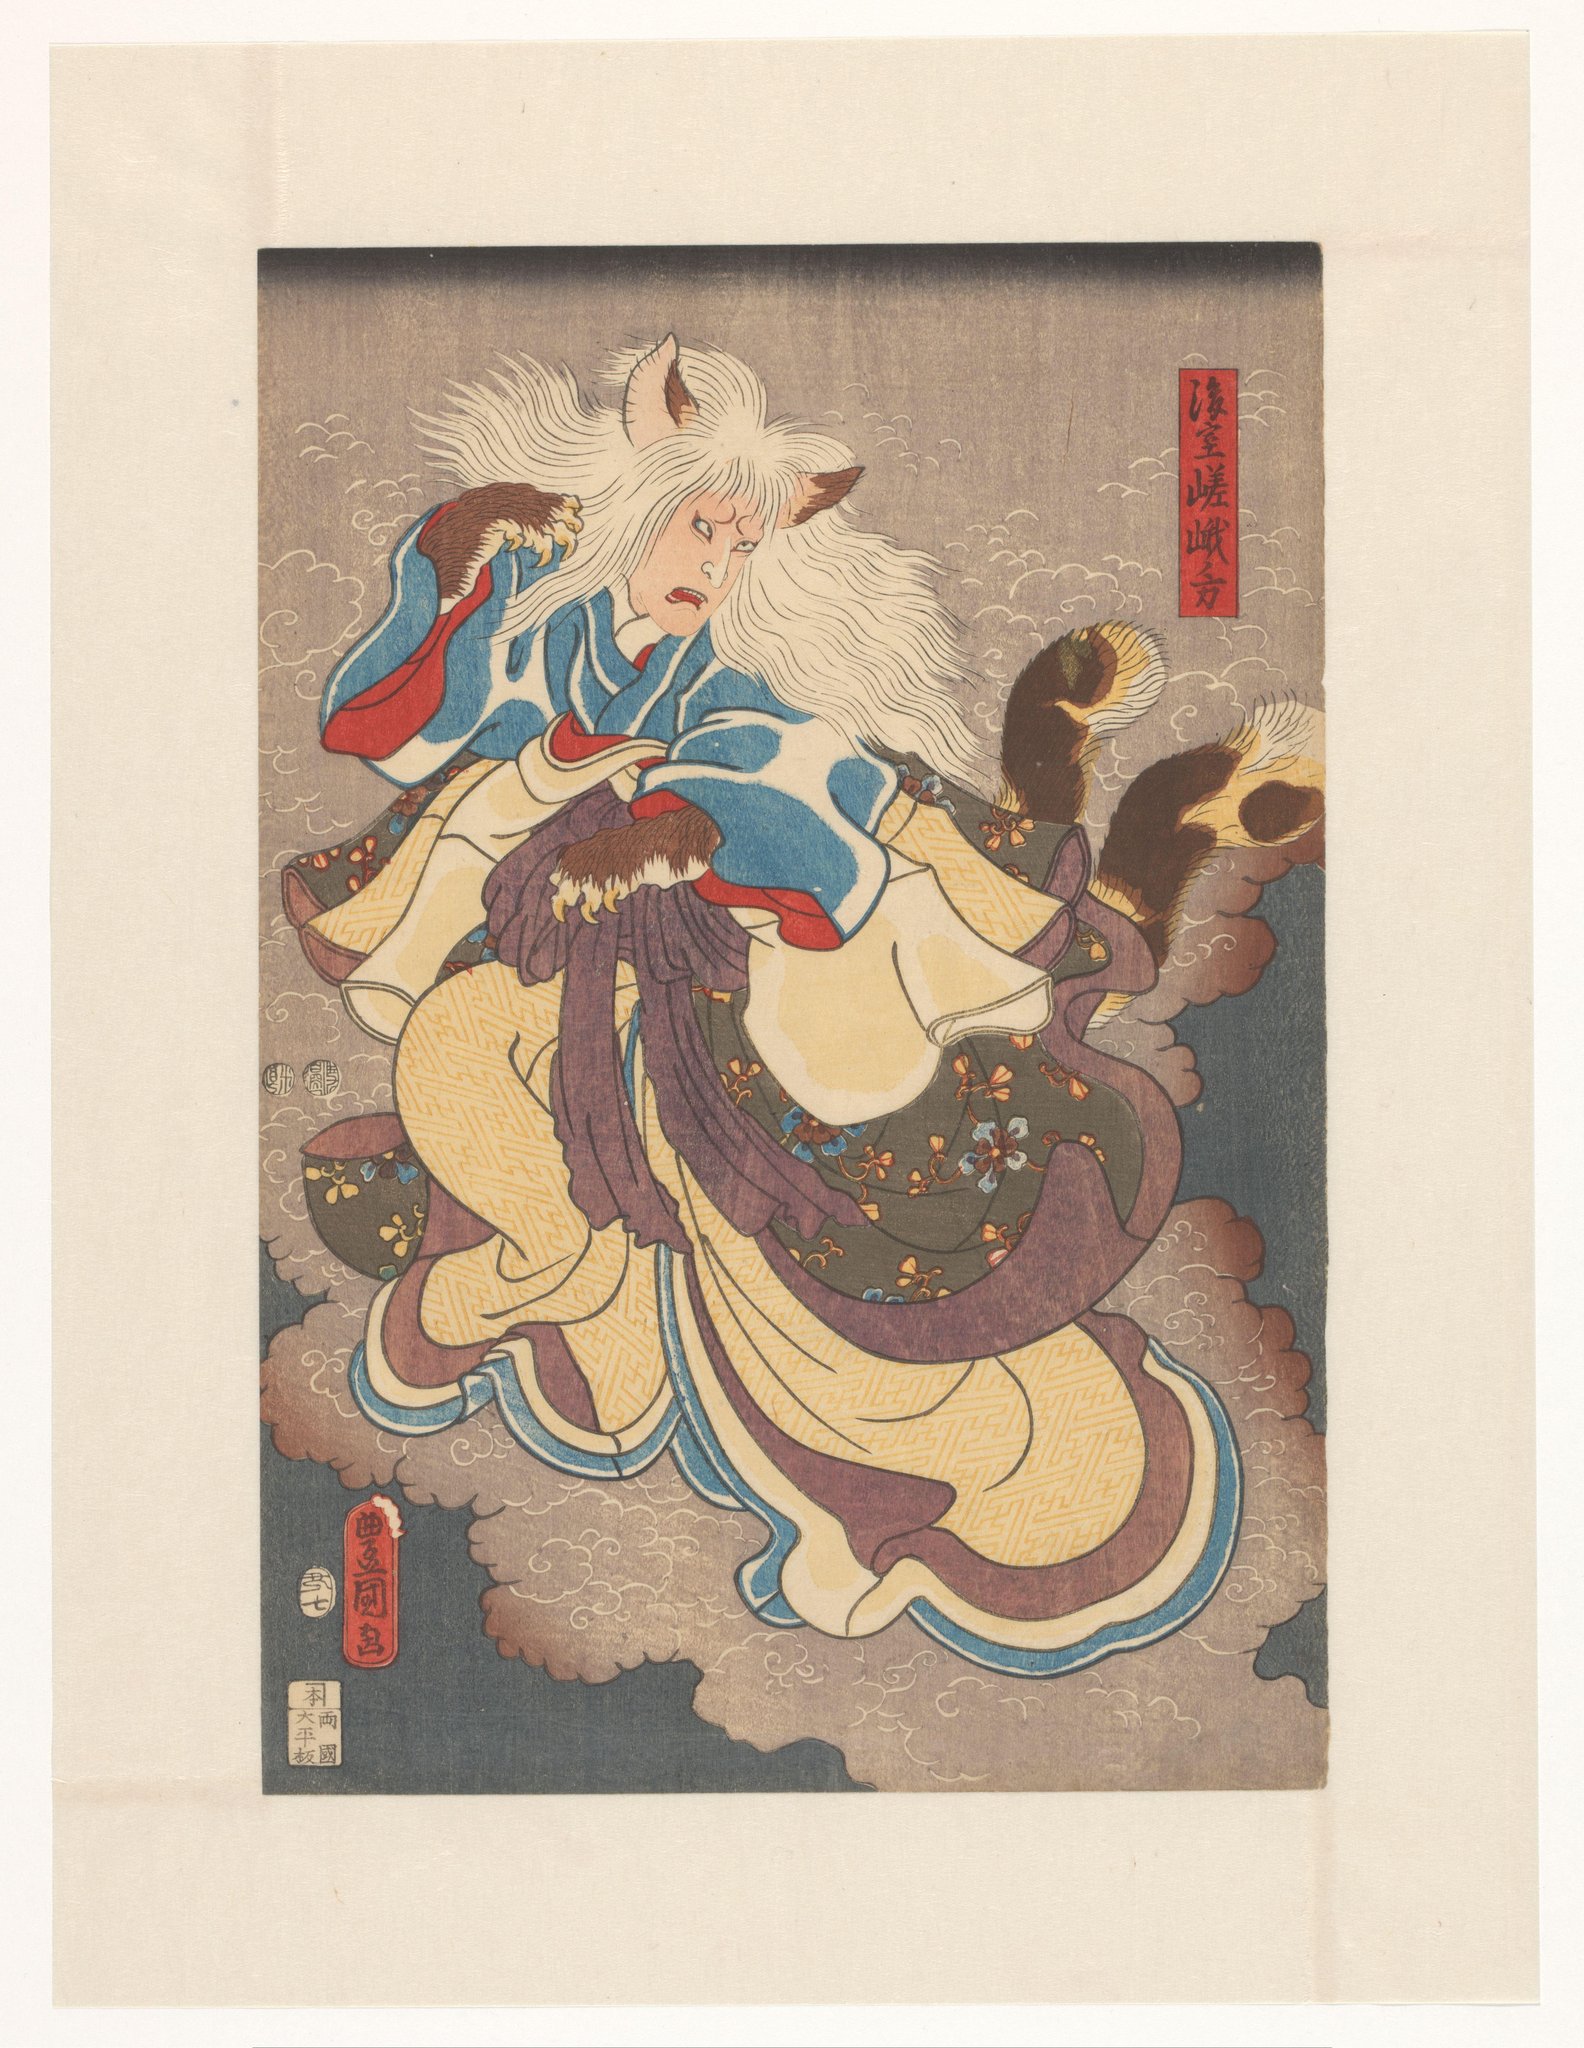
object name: print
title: Vampire cat of Nabeshima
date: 1807-1853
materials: paper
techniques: woodcut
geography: japan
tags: monsters of mixed human and animal shape; 'mostri' (ripa), group of actors, troupe; actors on the stage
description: Kabuki acteur Ichikawa Kodaji IV in de rol van kattenmonster. Na een ruzie in de Nabeshima familie, waarbij een trouwe vazal wordt gedood, kruipt zijn kat in het lichaam van de weduwe Saga no Kata, om als kattenmonster wraak te nemen.